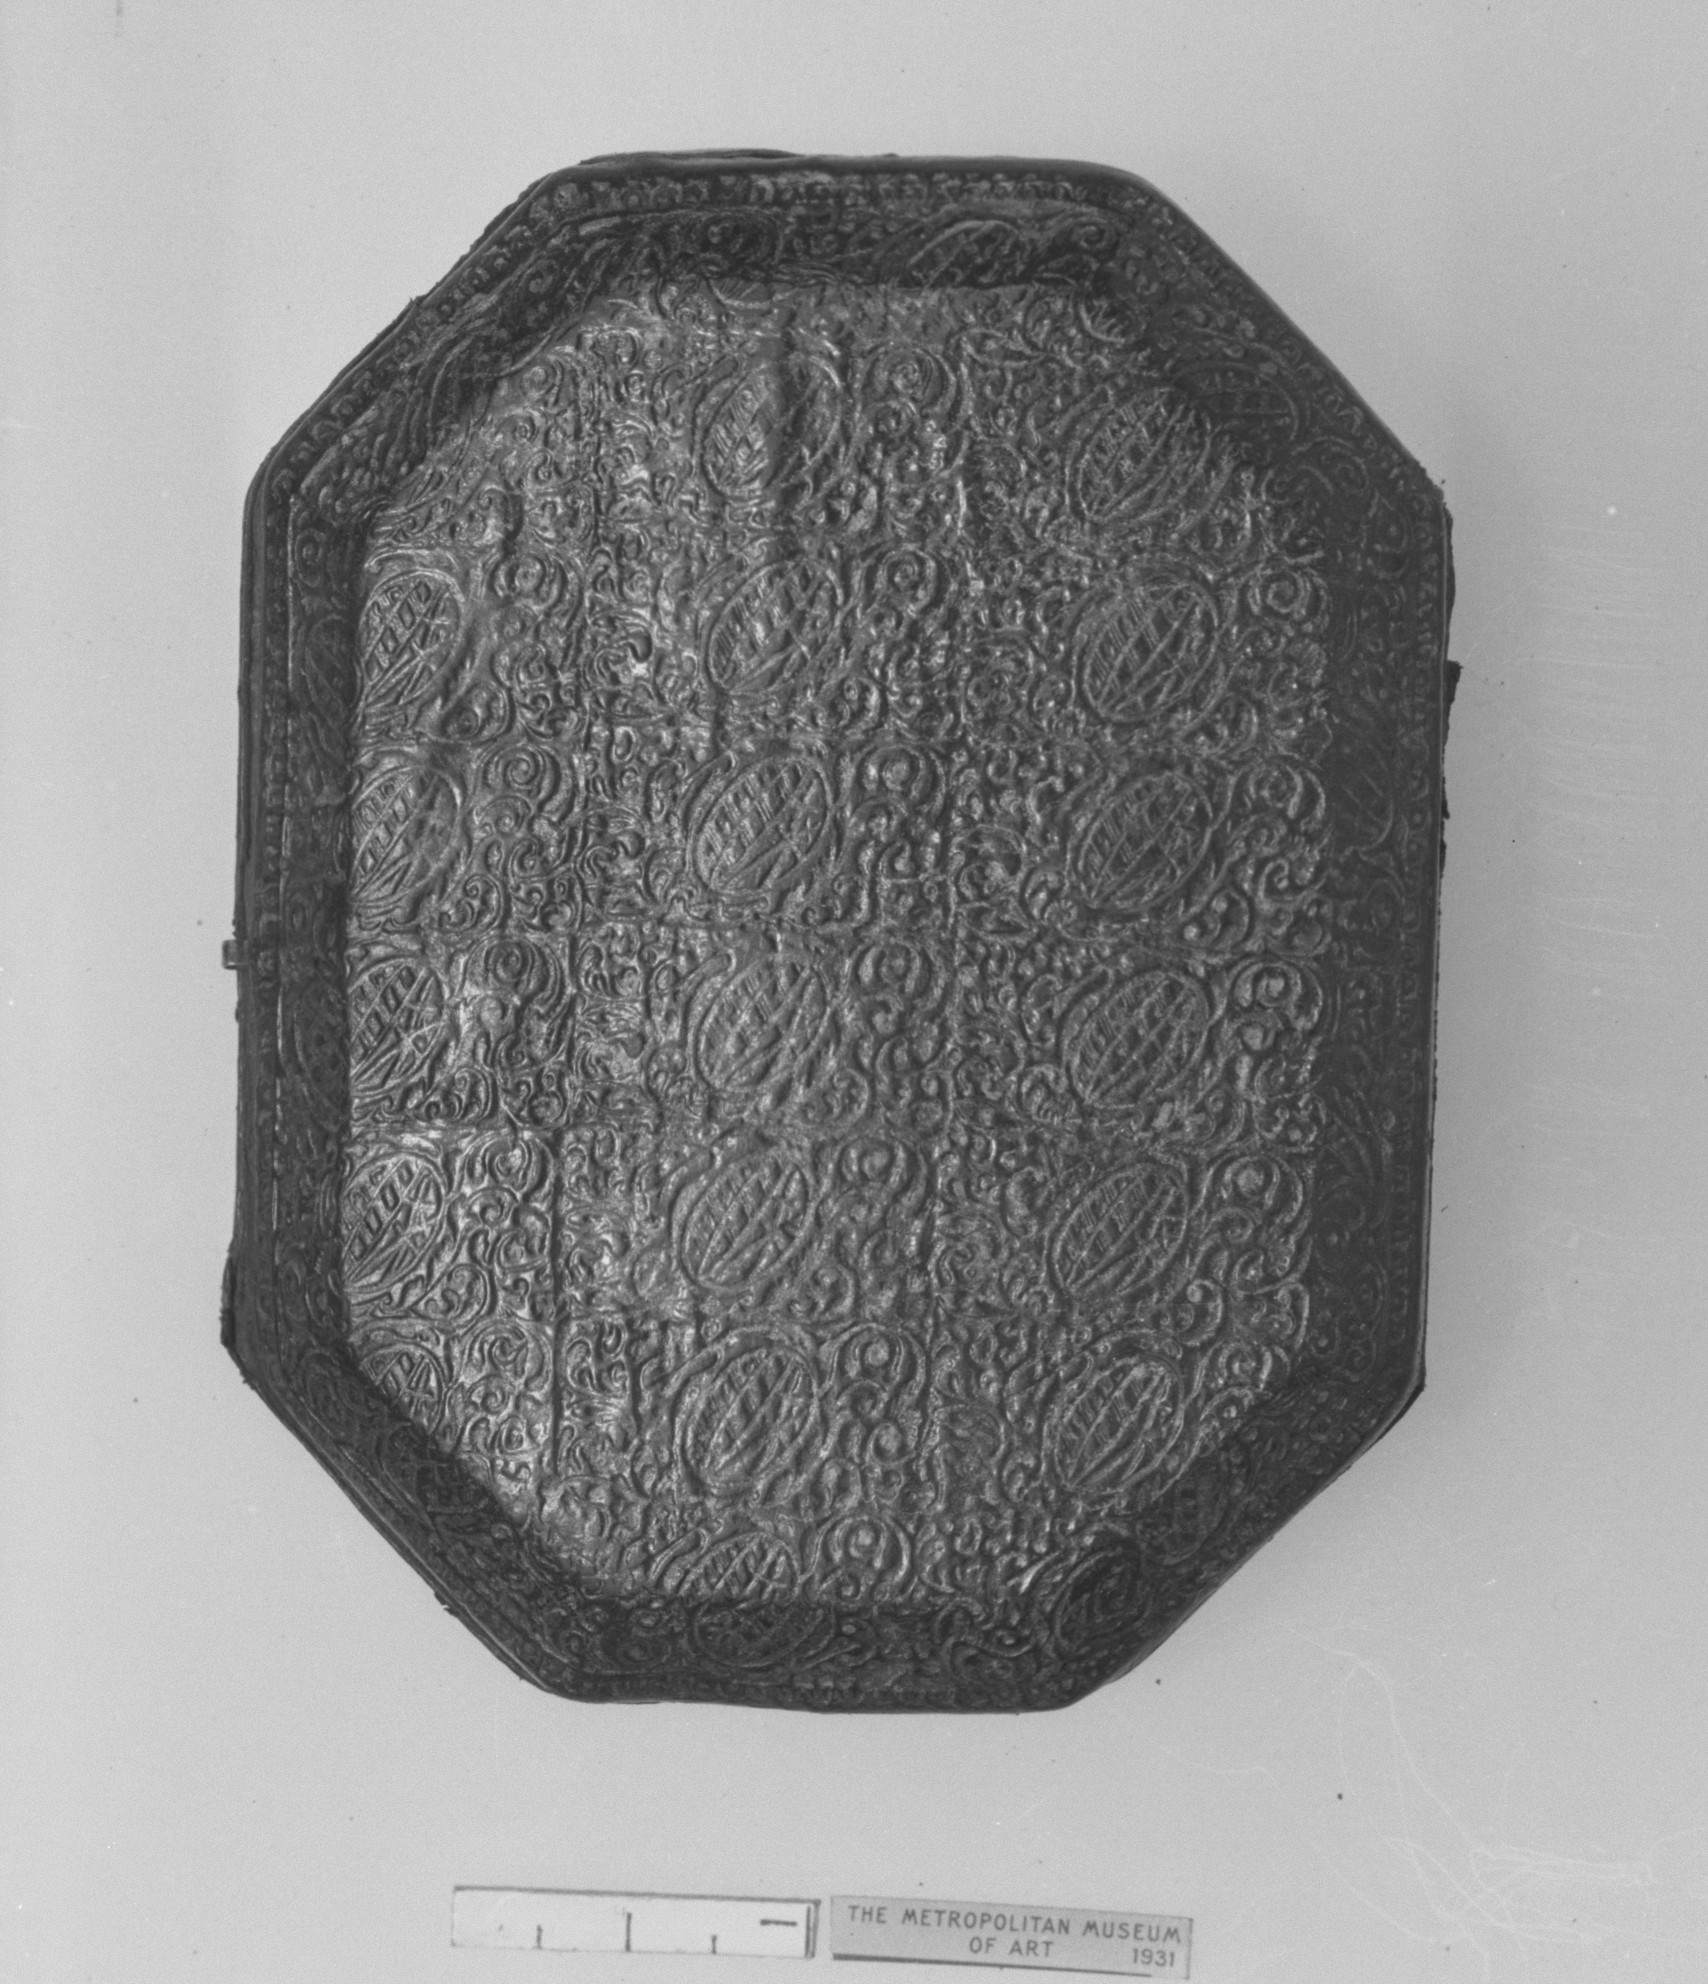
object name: box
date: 1601-1700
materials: gilt, leather